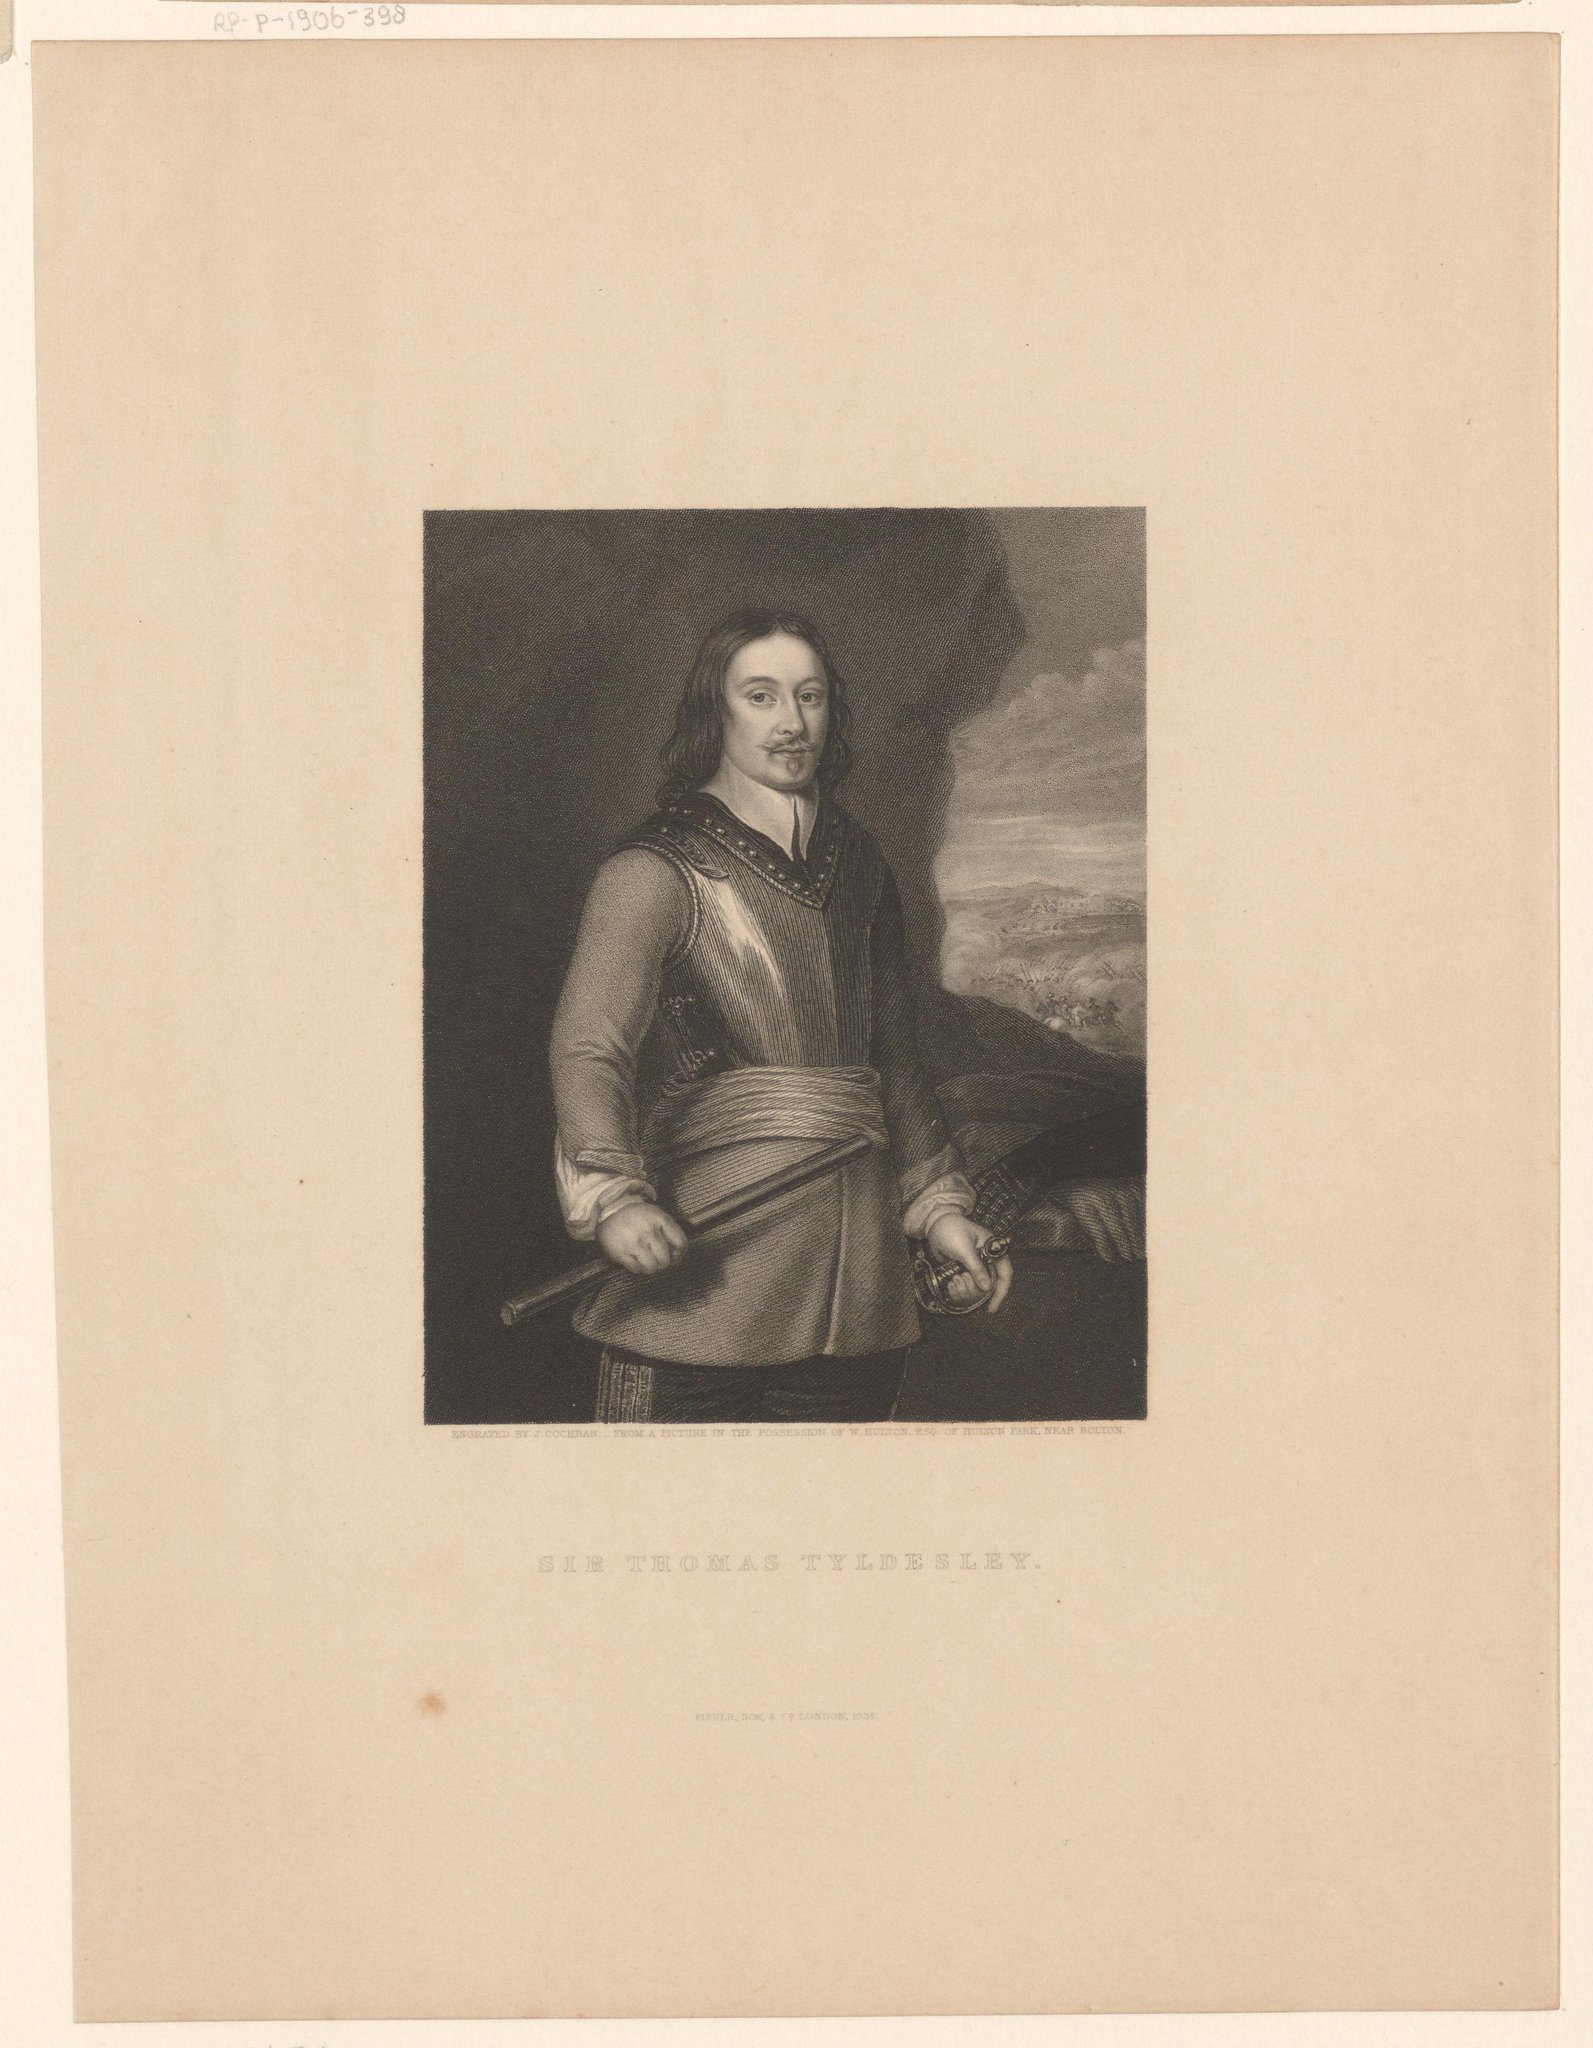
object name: print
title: Portret van Thomas Tyldesley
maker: john cochran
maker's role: painter, print maker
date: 1838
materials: paper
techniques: etching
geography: london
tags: commander-in-chief, general, marshal, historical persons, baton of general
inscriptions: collector's mark: Lugt 2228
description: Prent is gebruikt in: Bain, Thomas. Lancashire and Cheshire, past and present (...). Glasgow, Edinburgh en Londen: William Mackenzie, 1836.